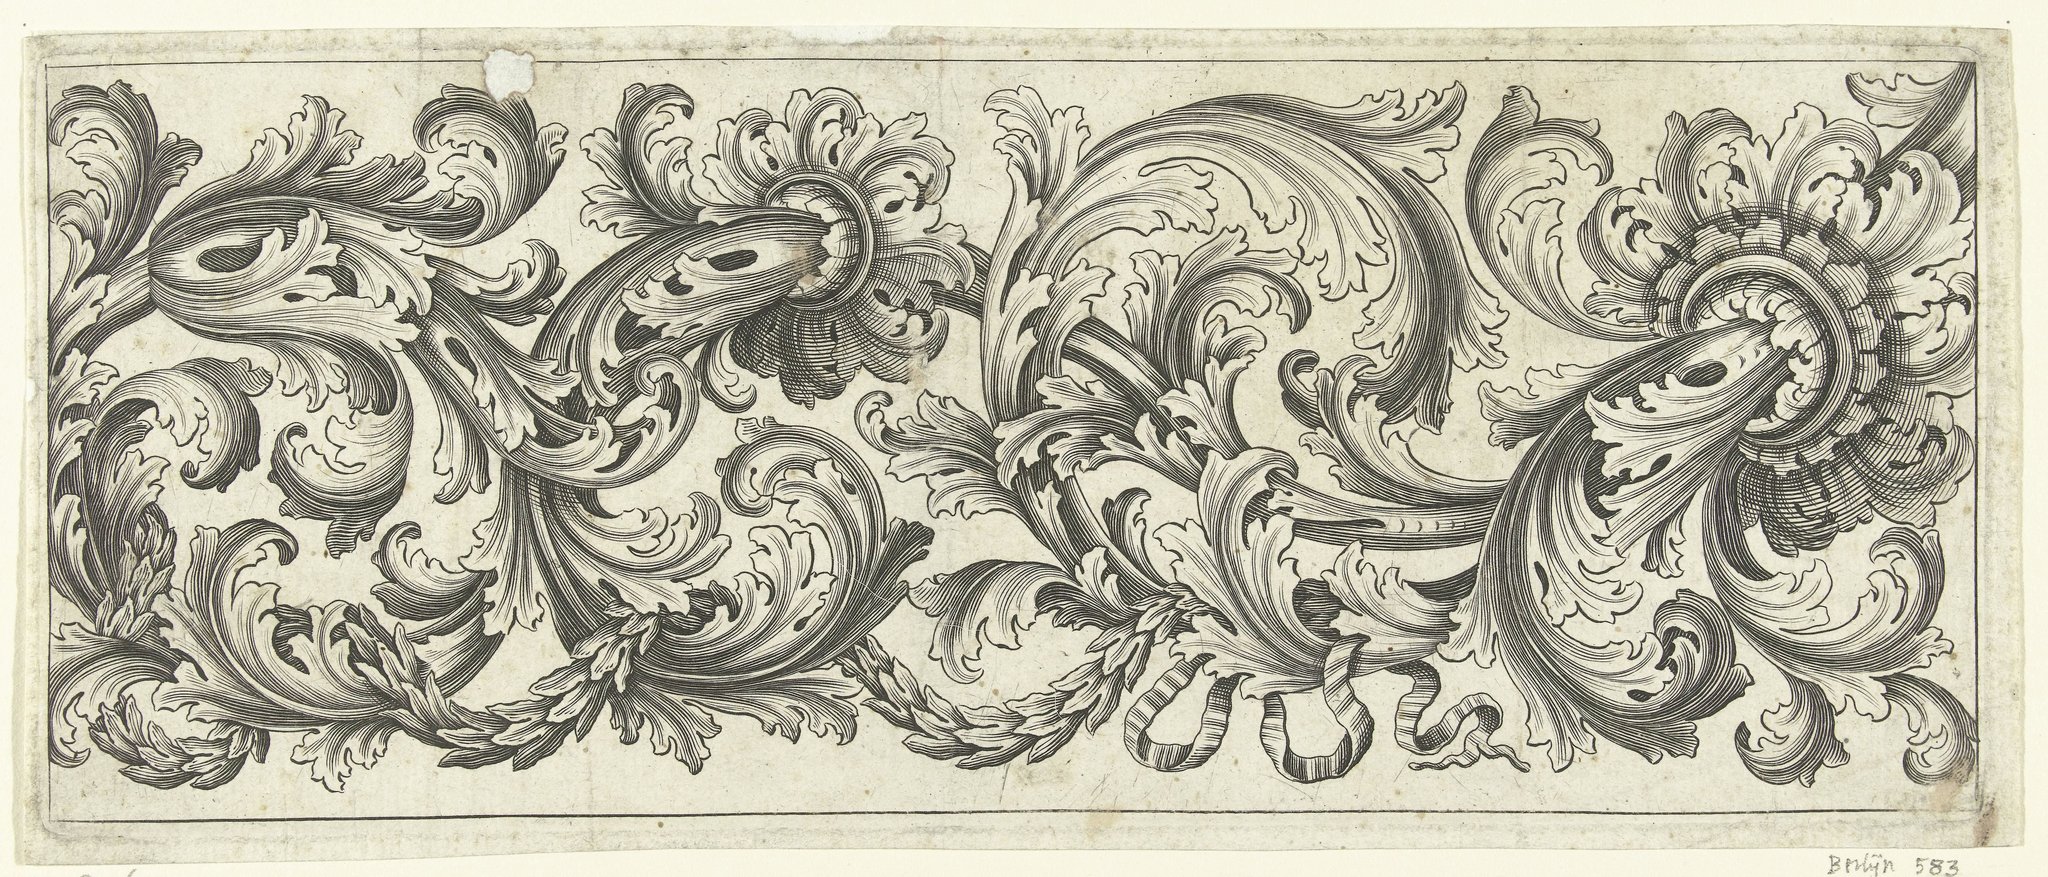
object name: print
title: Friezen met bladranken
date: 1656-1660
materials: paper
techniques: engraving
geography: france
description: Bladrank ontspruitend uit rozet. Blad 4 uit serie van 12 bladen.